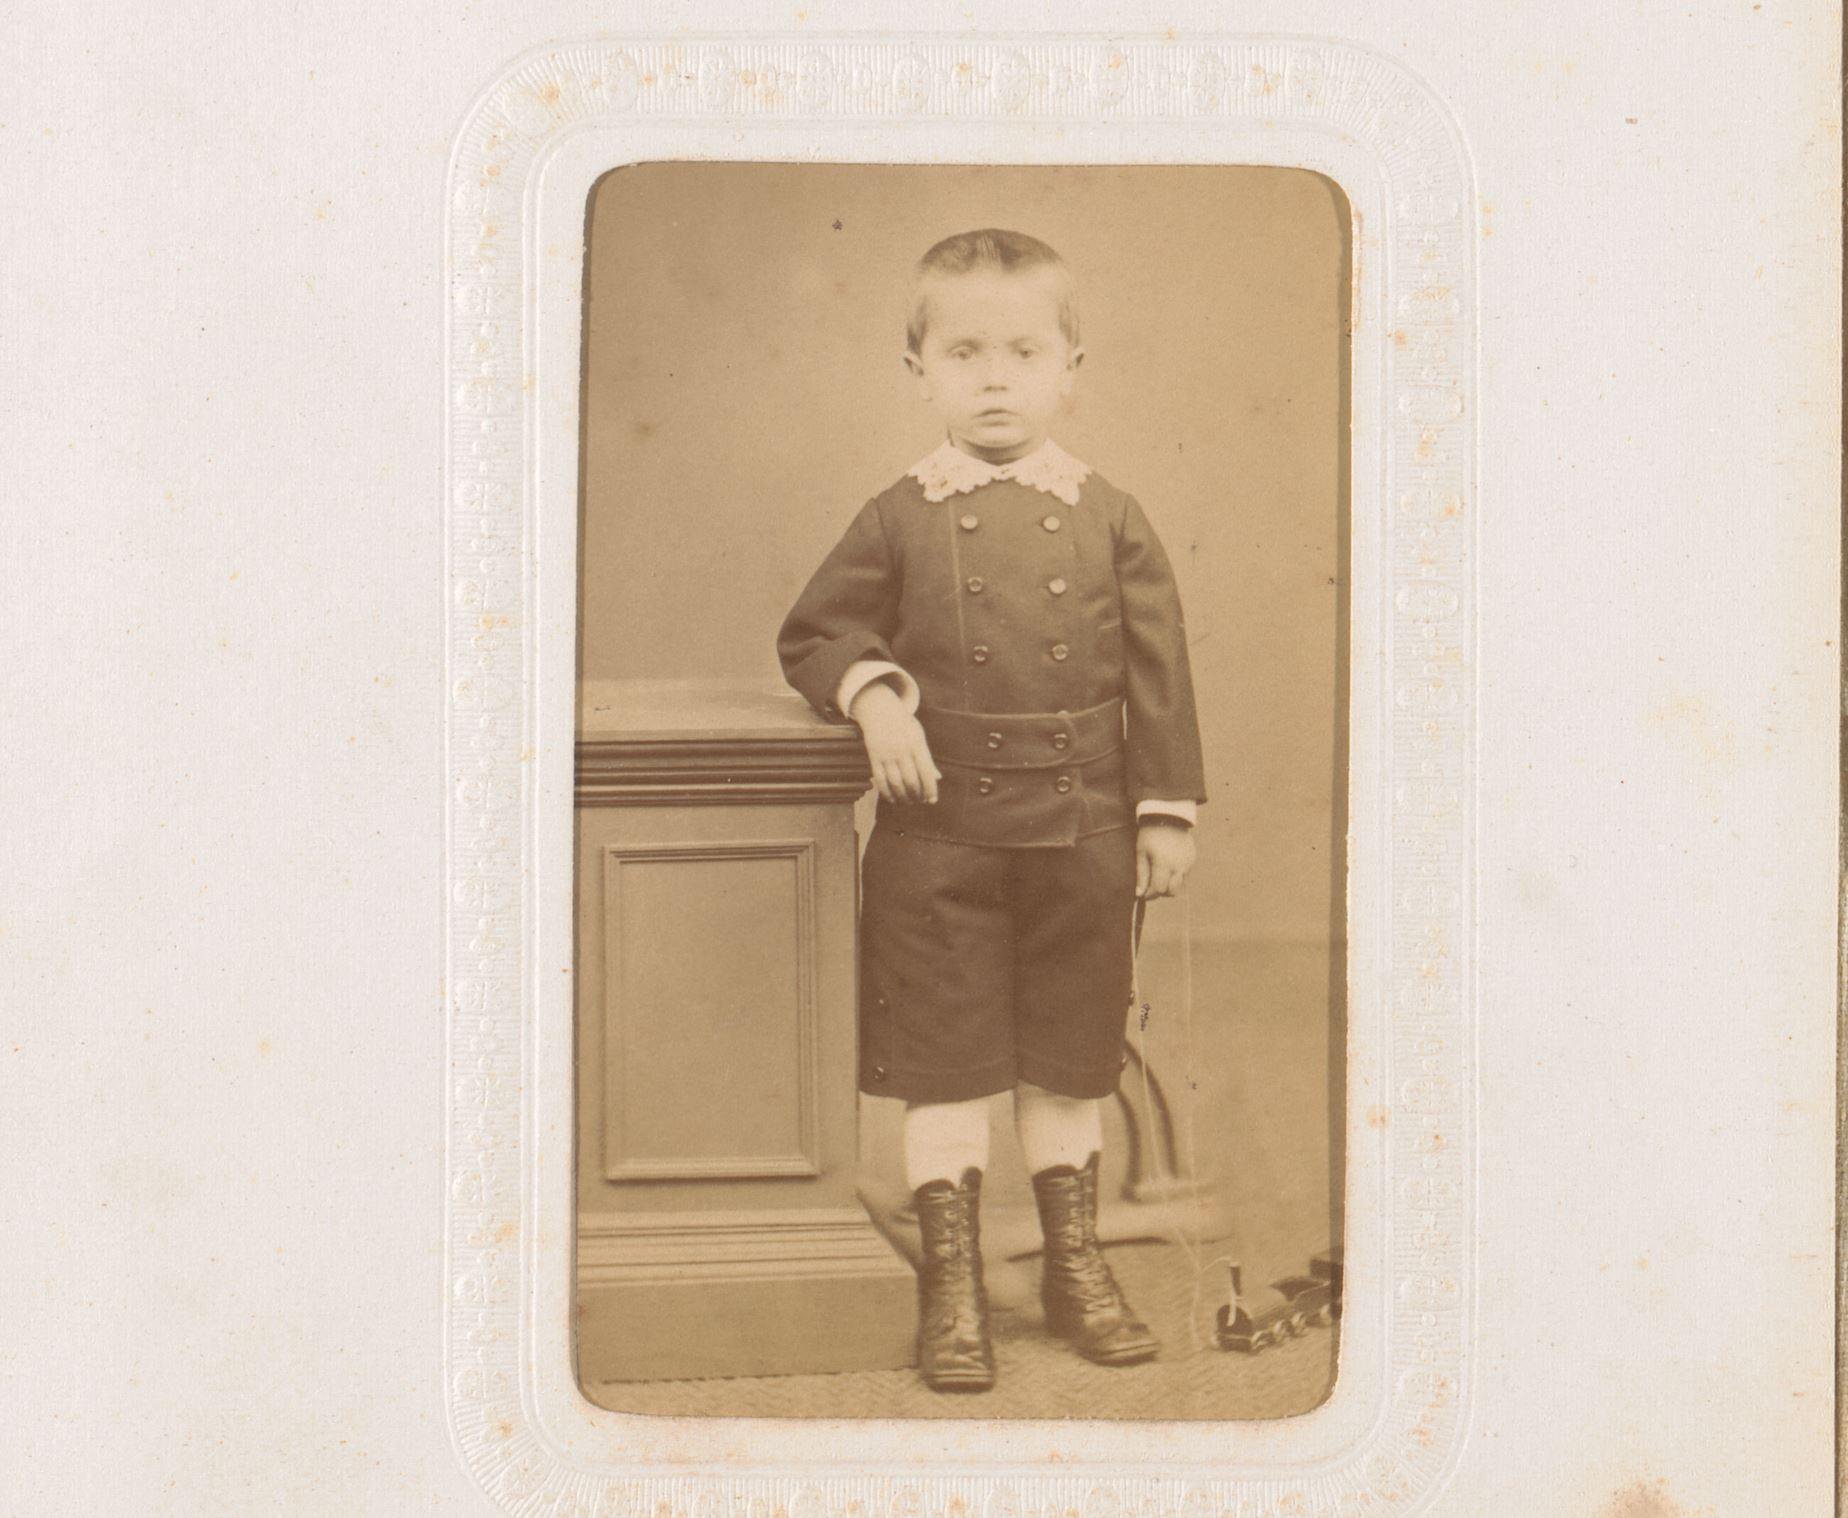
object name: photograph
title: Portret van een jongen met een speelgoed trein aan een touw, staand bij een zuil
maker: Anonymous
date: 1860-1900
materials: cardboard, photographic support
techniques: albumen print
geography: netherlands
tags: historical persons, toddler (male), pedestal of a piece of sculpture (perhaps in the form of a herm), (playing with) train